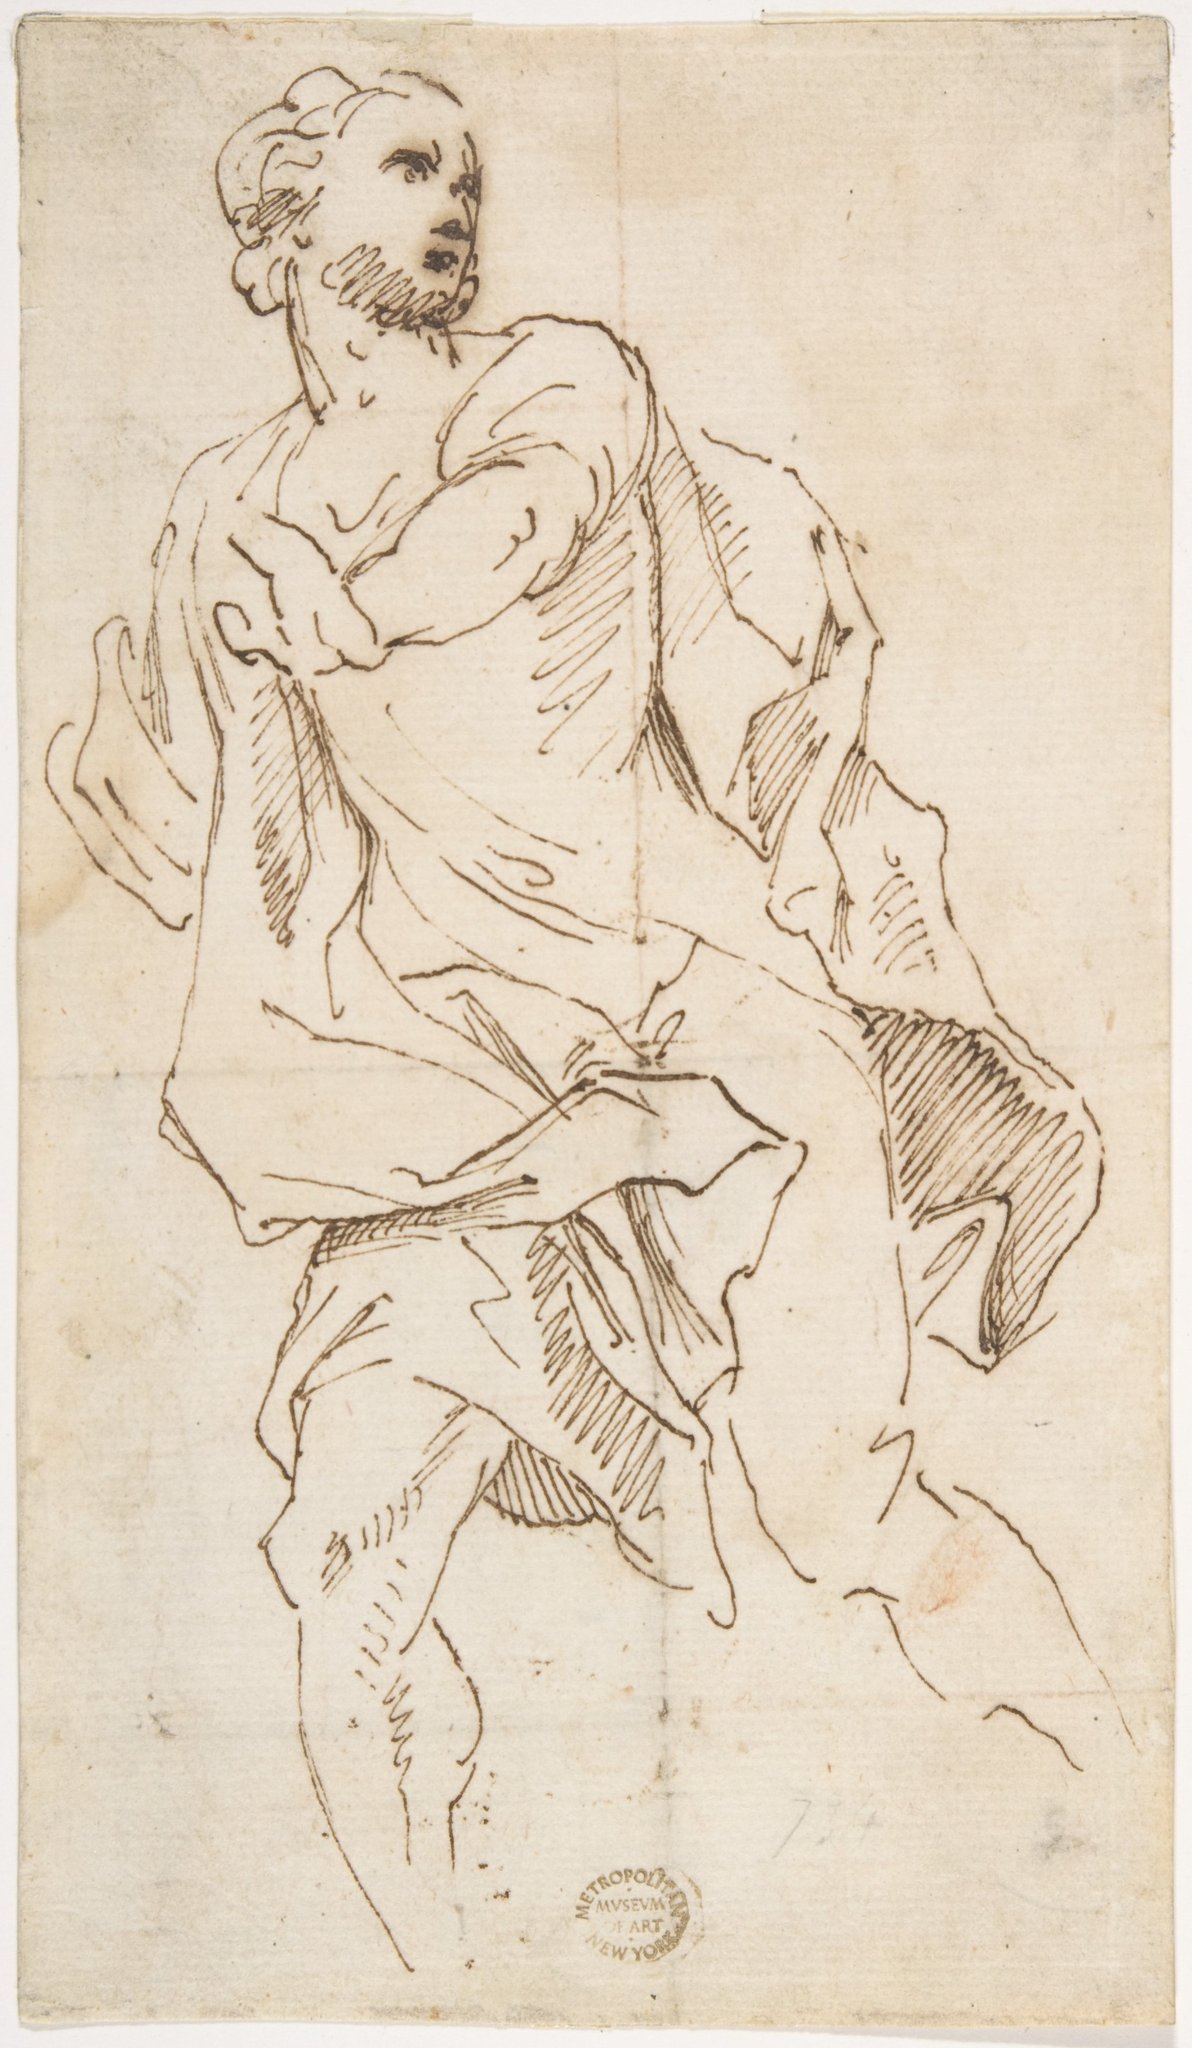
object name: drawing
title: Male Figure Running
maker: giovanni lanfranco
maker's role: artist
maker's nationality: italian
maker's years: 1582-1647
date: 1582-1647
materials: ink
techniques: pen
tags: men,running